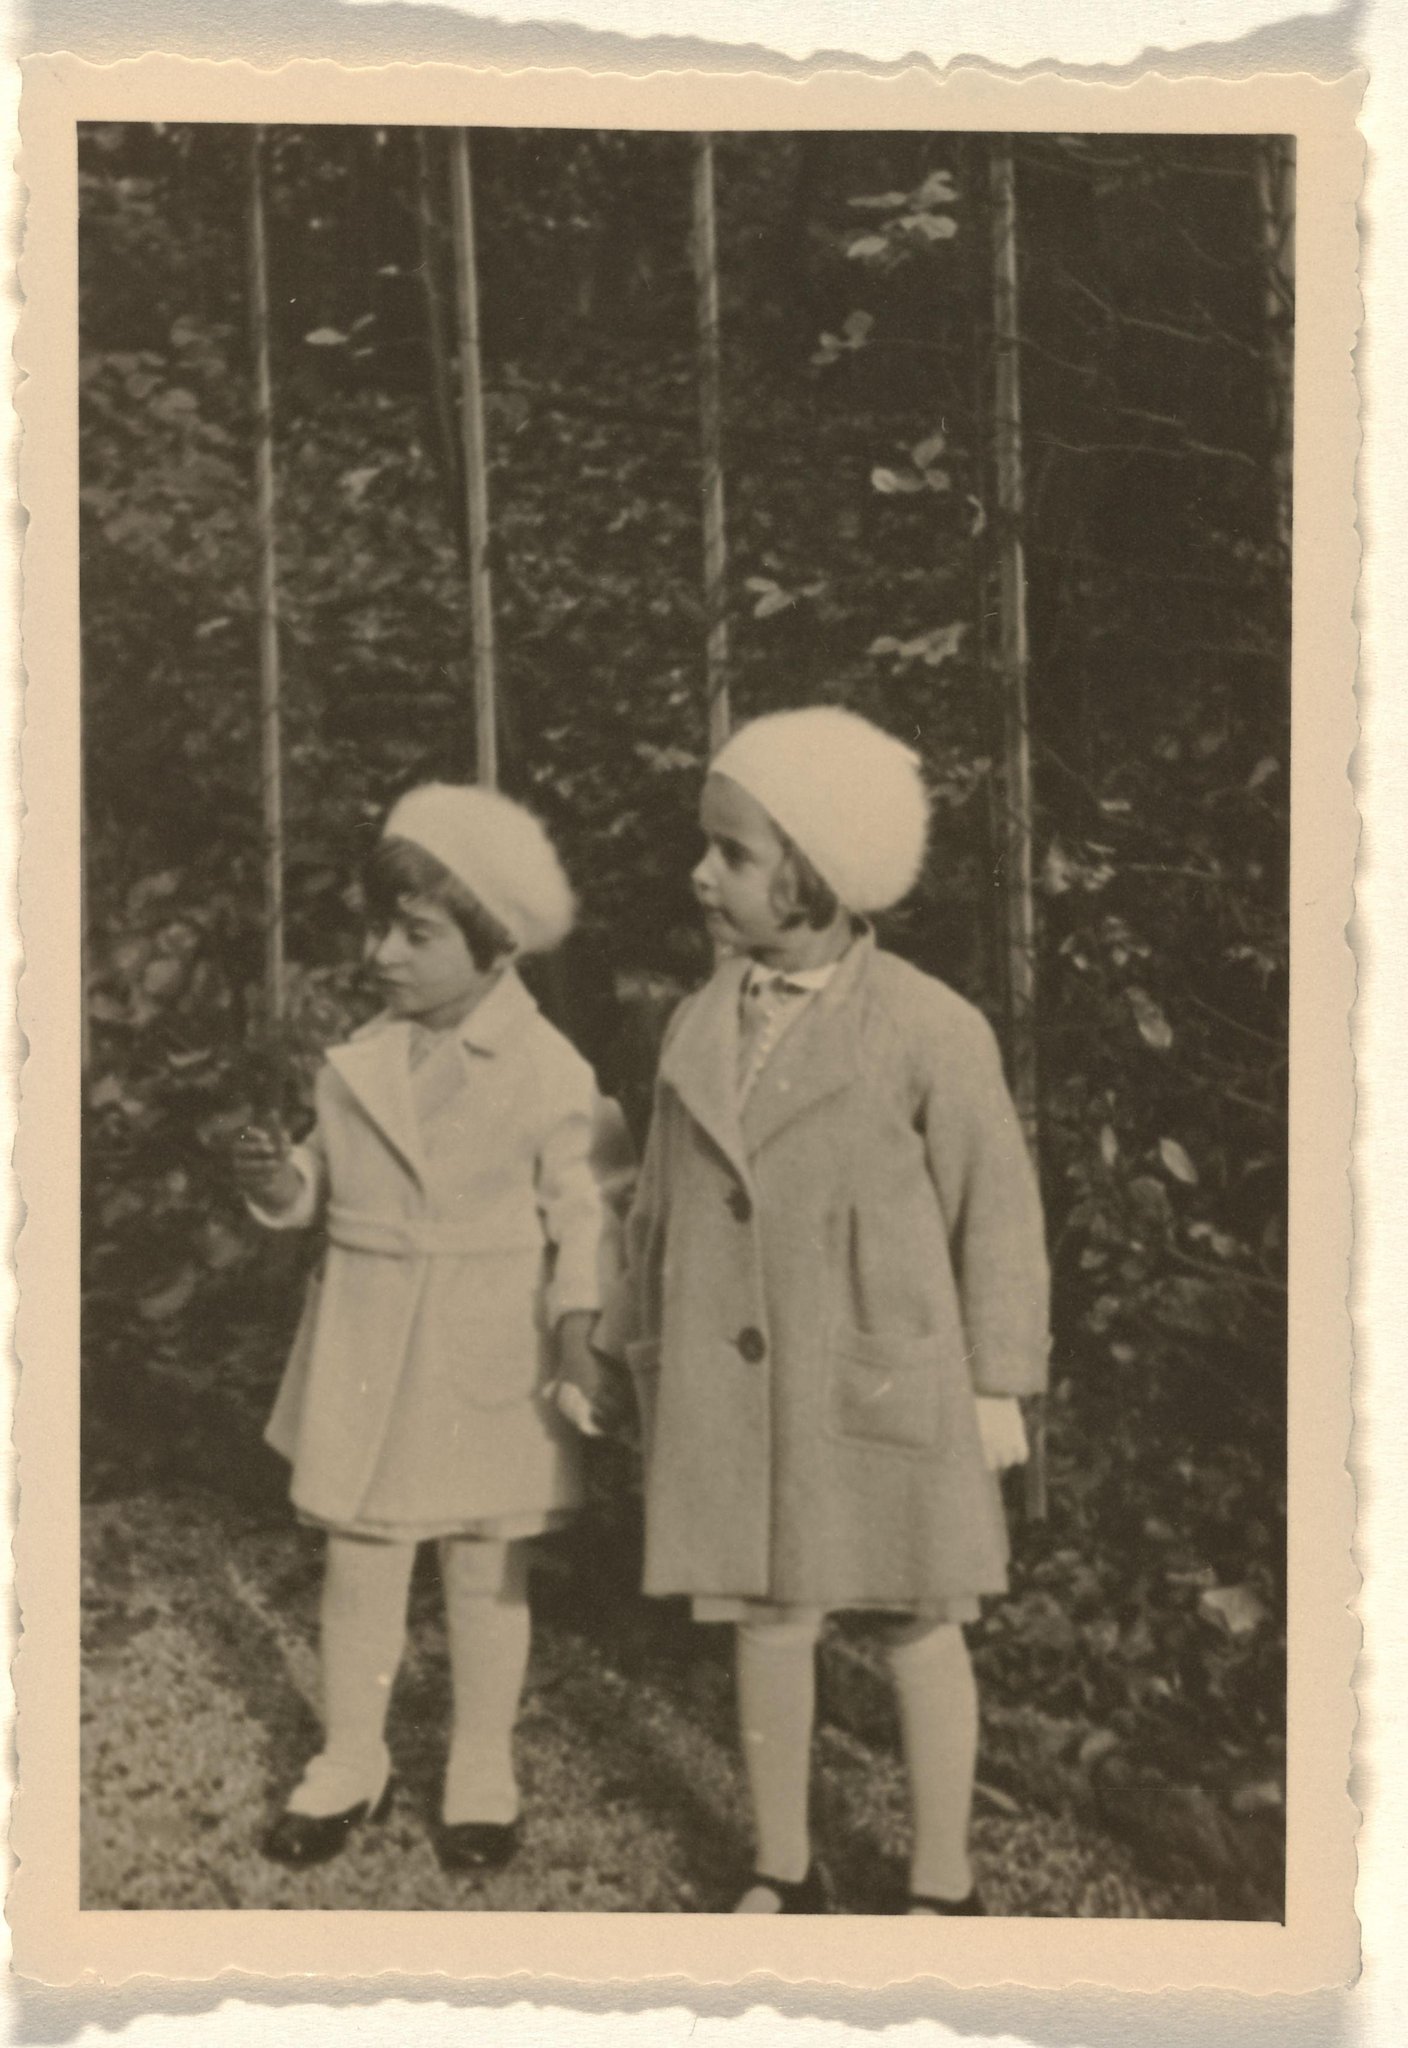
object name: photograph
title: Isabel Wachenheimer en een onbekend meisje in Württemberg in januari 1933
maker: Anonymous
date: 1901-1933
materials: photographic support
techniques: gelatin silver print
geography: württemberg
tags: leiden, isabel wachenheimer-elon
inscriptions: date: ‘Würt.32-33.’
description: Dit object is onderdeel van de nalatenschap van Isabel Elon-Wachenheimer (1928-2010). Tot haar overlijden behoorde het samen met de andere objecten uit de nalatenschap tot haar privédomein van Isabel Wachenheimer. In die particuliere context zijn deze objecten tezamen en individueel aandenkens - aan de jeugd, ouders en familie van Isabel Wachenheimer vóór en tijdens de Shoah en aan haar leven na de Tweede Wereldoorlog. Isabel Wachenheimer, die van juni 1943 tot mei 1945 gevangen zat in Kamp Westerbork, Theresienstadt, Auschwitz, Lenzing a/d Oberdonau (een buitenkamp van Mauthausen), overleefde de Shoah. Haar ouders – Eugène Wachenheimer en Else Wachenheimer-Moos - werden op 14 oktober 1944 in Auschwitz-Birkenau vermoord.